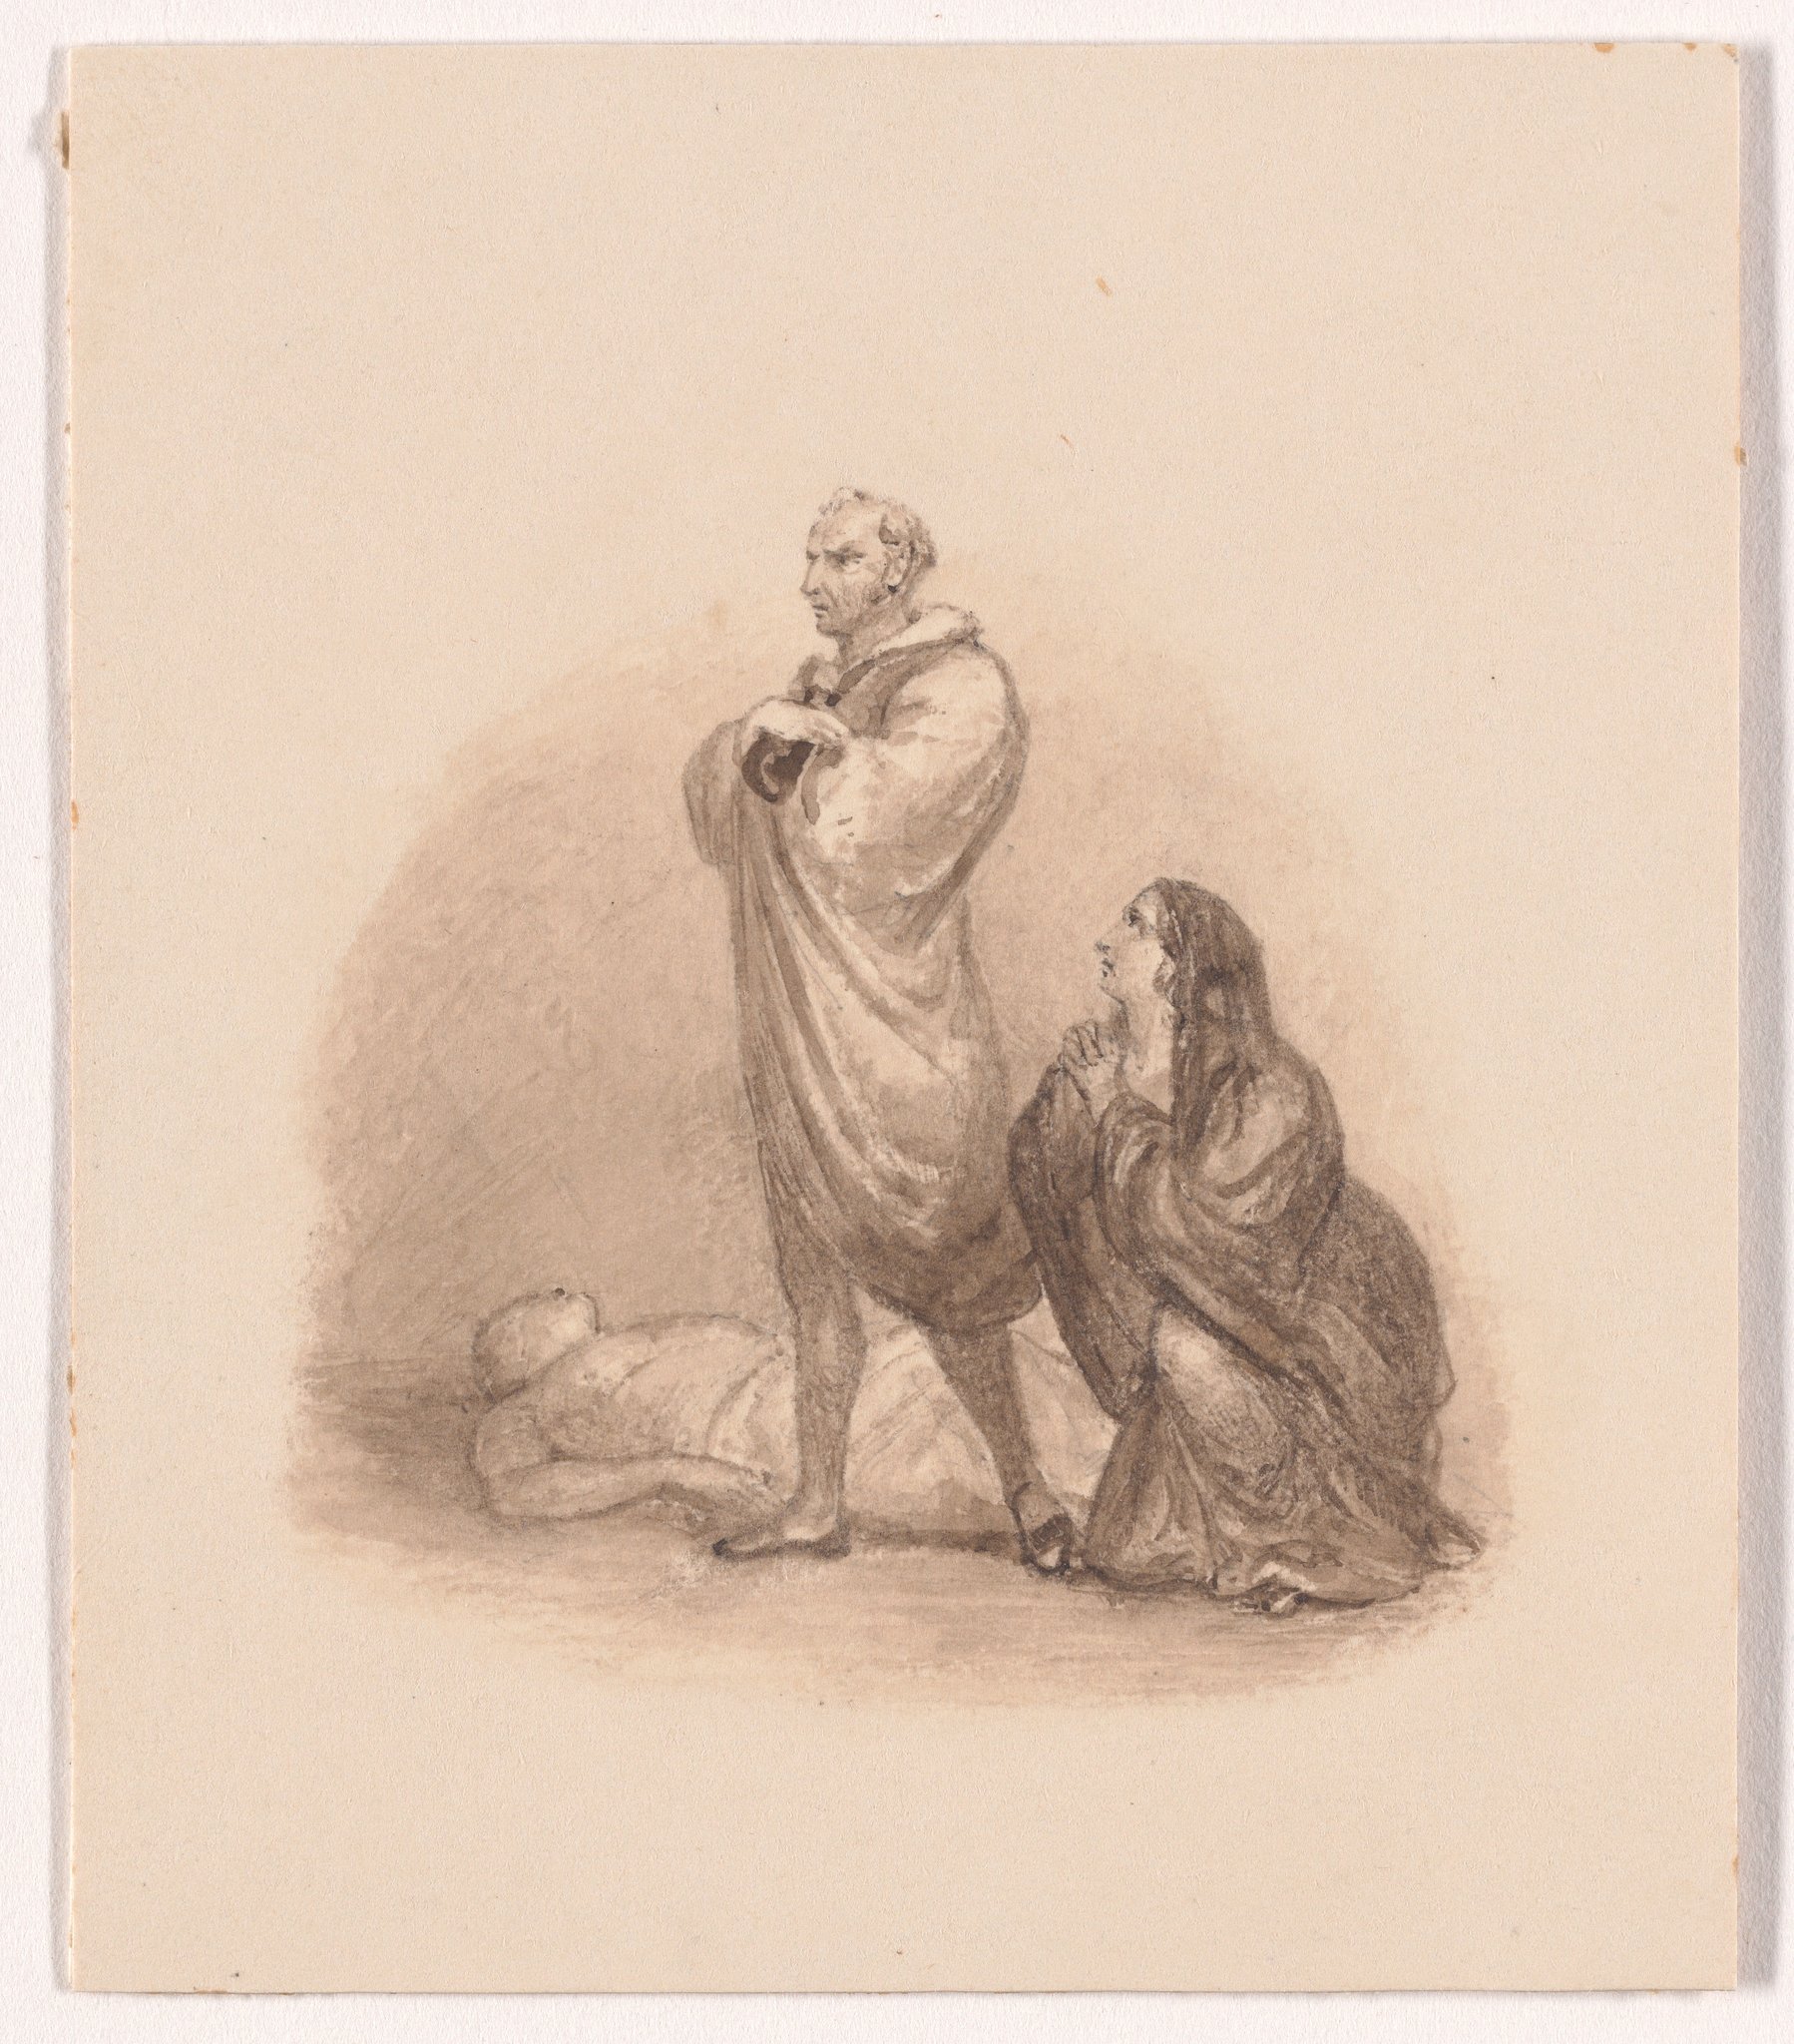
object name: drawing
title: Illustration design for "The Economy of Human Life"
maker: frank howard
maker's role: artist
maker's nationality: british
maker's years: 1805-1866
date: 1834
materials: ink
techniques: brush, pen, wash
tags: men,women